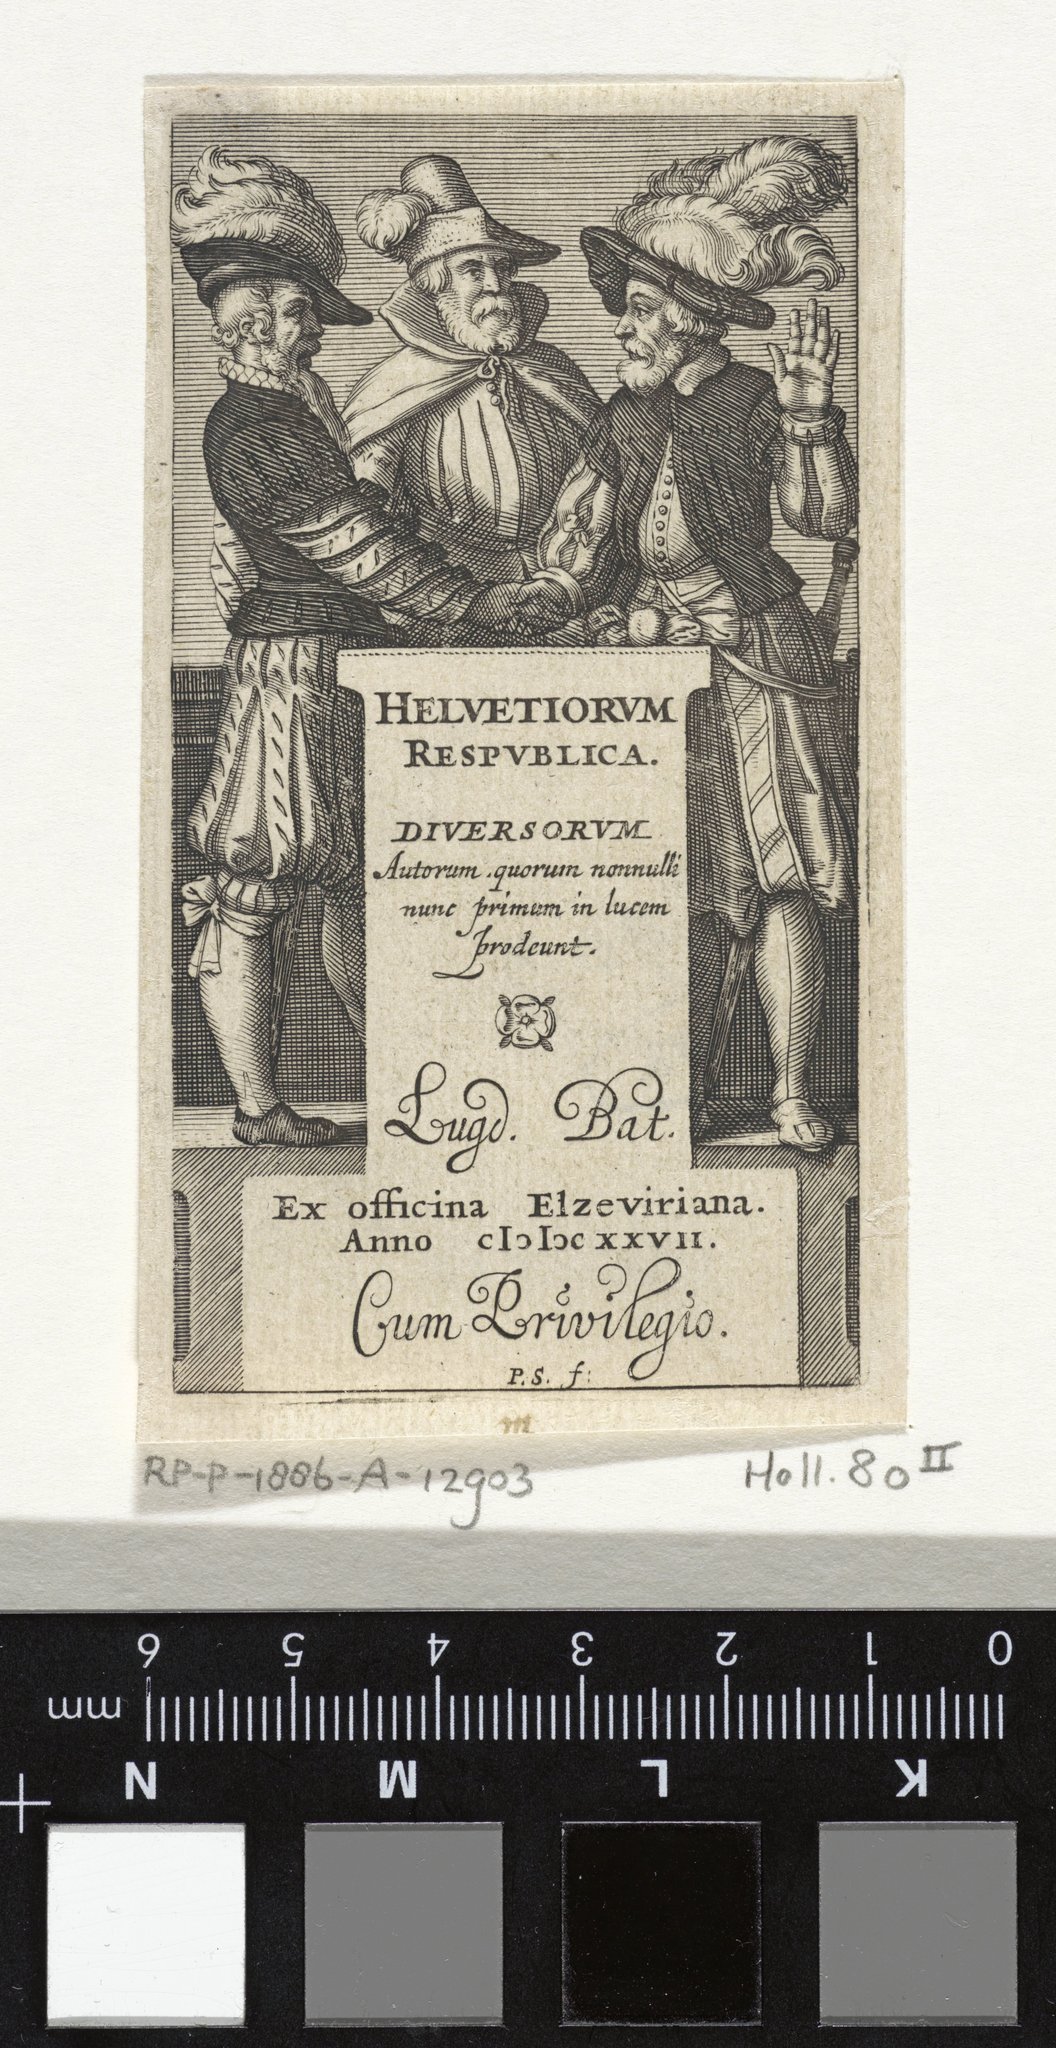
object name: print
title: Drie Zwitsers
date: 1628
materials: paper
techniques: engraving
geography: amsterdam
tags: europeans (with name)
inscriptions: collector's mark: Lugt 2228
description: Twee Zwitserse mannen schudden elkaar de hand, waarbij er een zijn andere hand opsteekt. Een derde man kijkt toe. Zij staan bij een voetstuk, waarop de titel van het boek weergegeven staat, met daaronder het impressum.